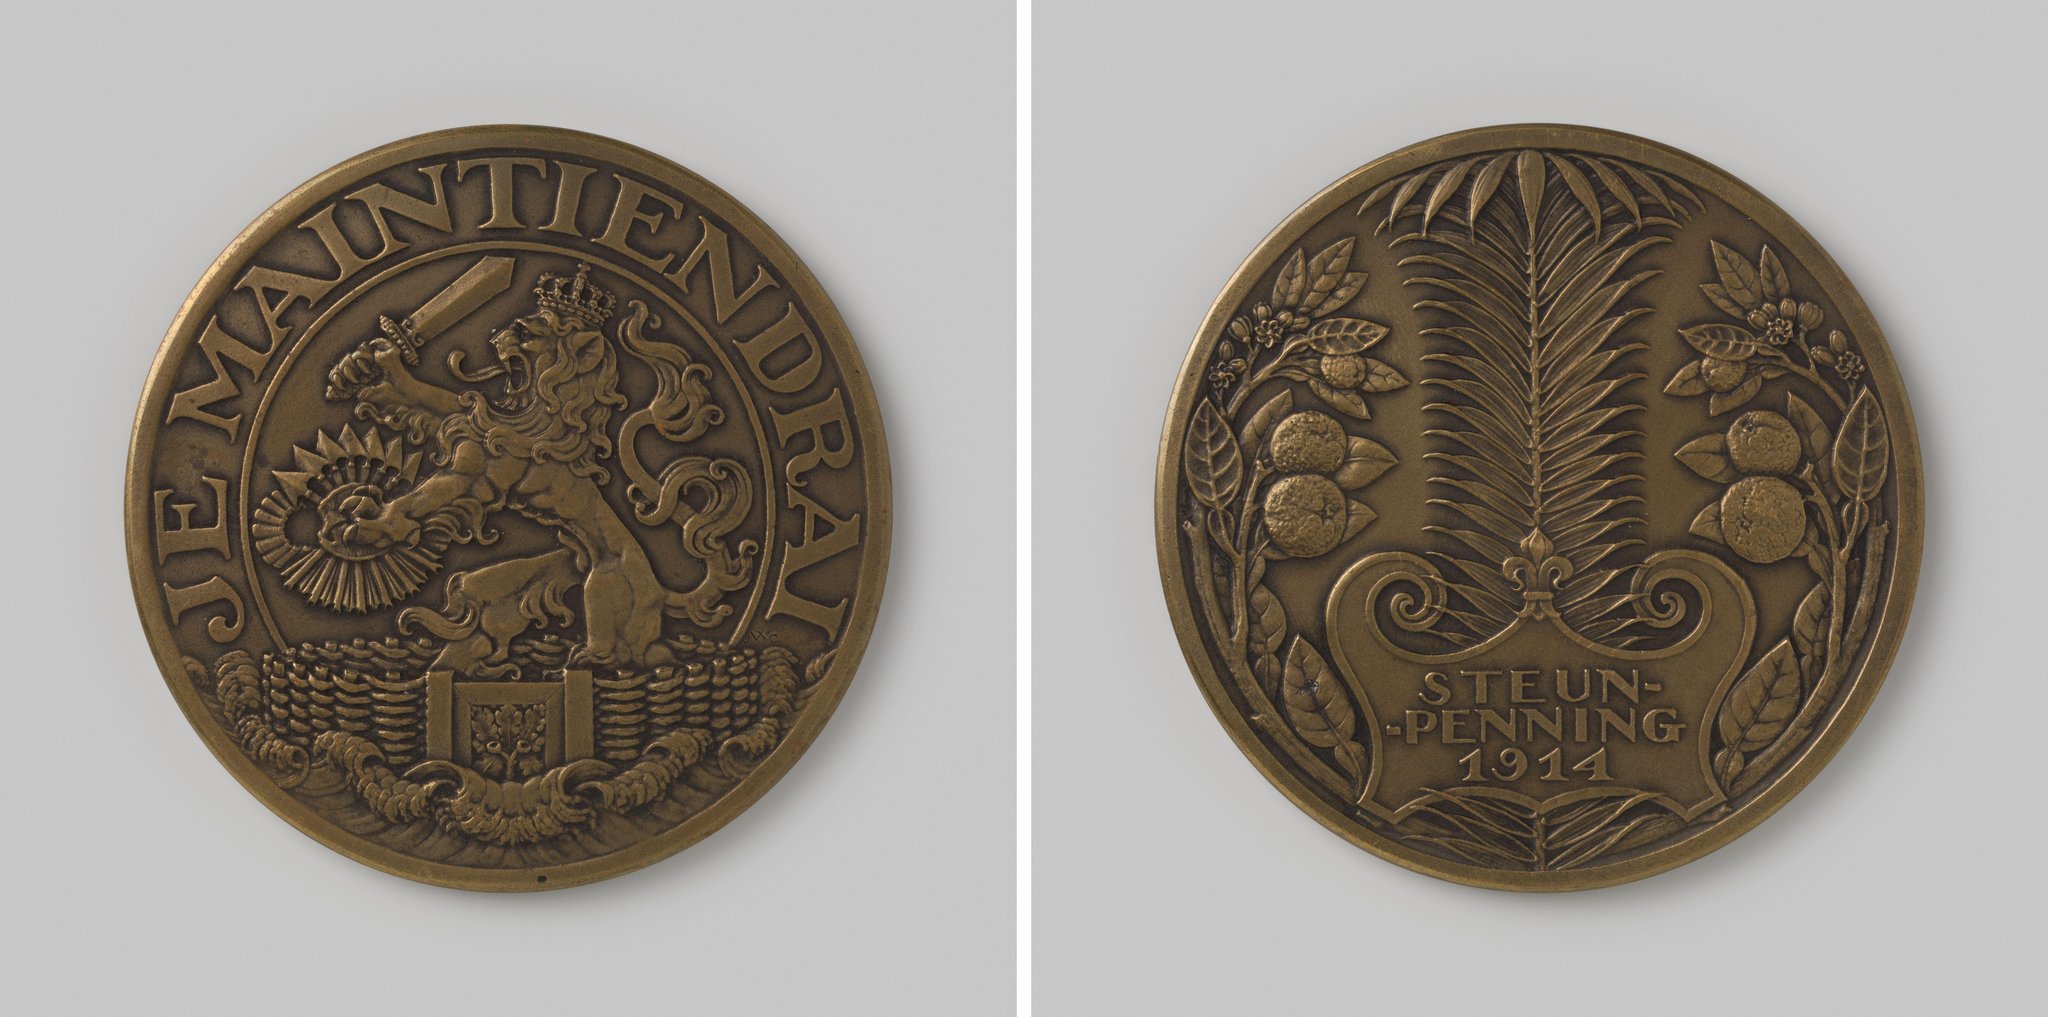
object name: history medal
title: Steunpenning 1914 (groot model)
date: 1914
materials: bronze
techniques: striking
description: Bronzen penning, op de voorzijde de Nederlandse Leeuw in een omheinde tuin, door golven bedreigd, met omschrift, op de keerzijde een geleliede vuurslag met opschrift op een recht opstijgende palmtak, tussen twee oranjetakken.